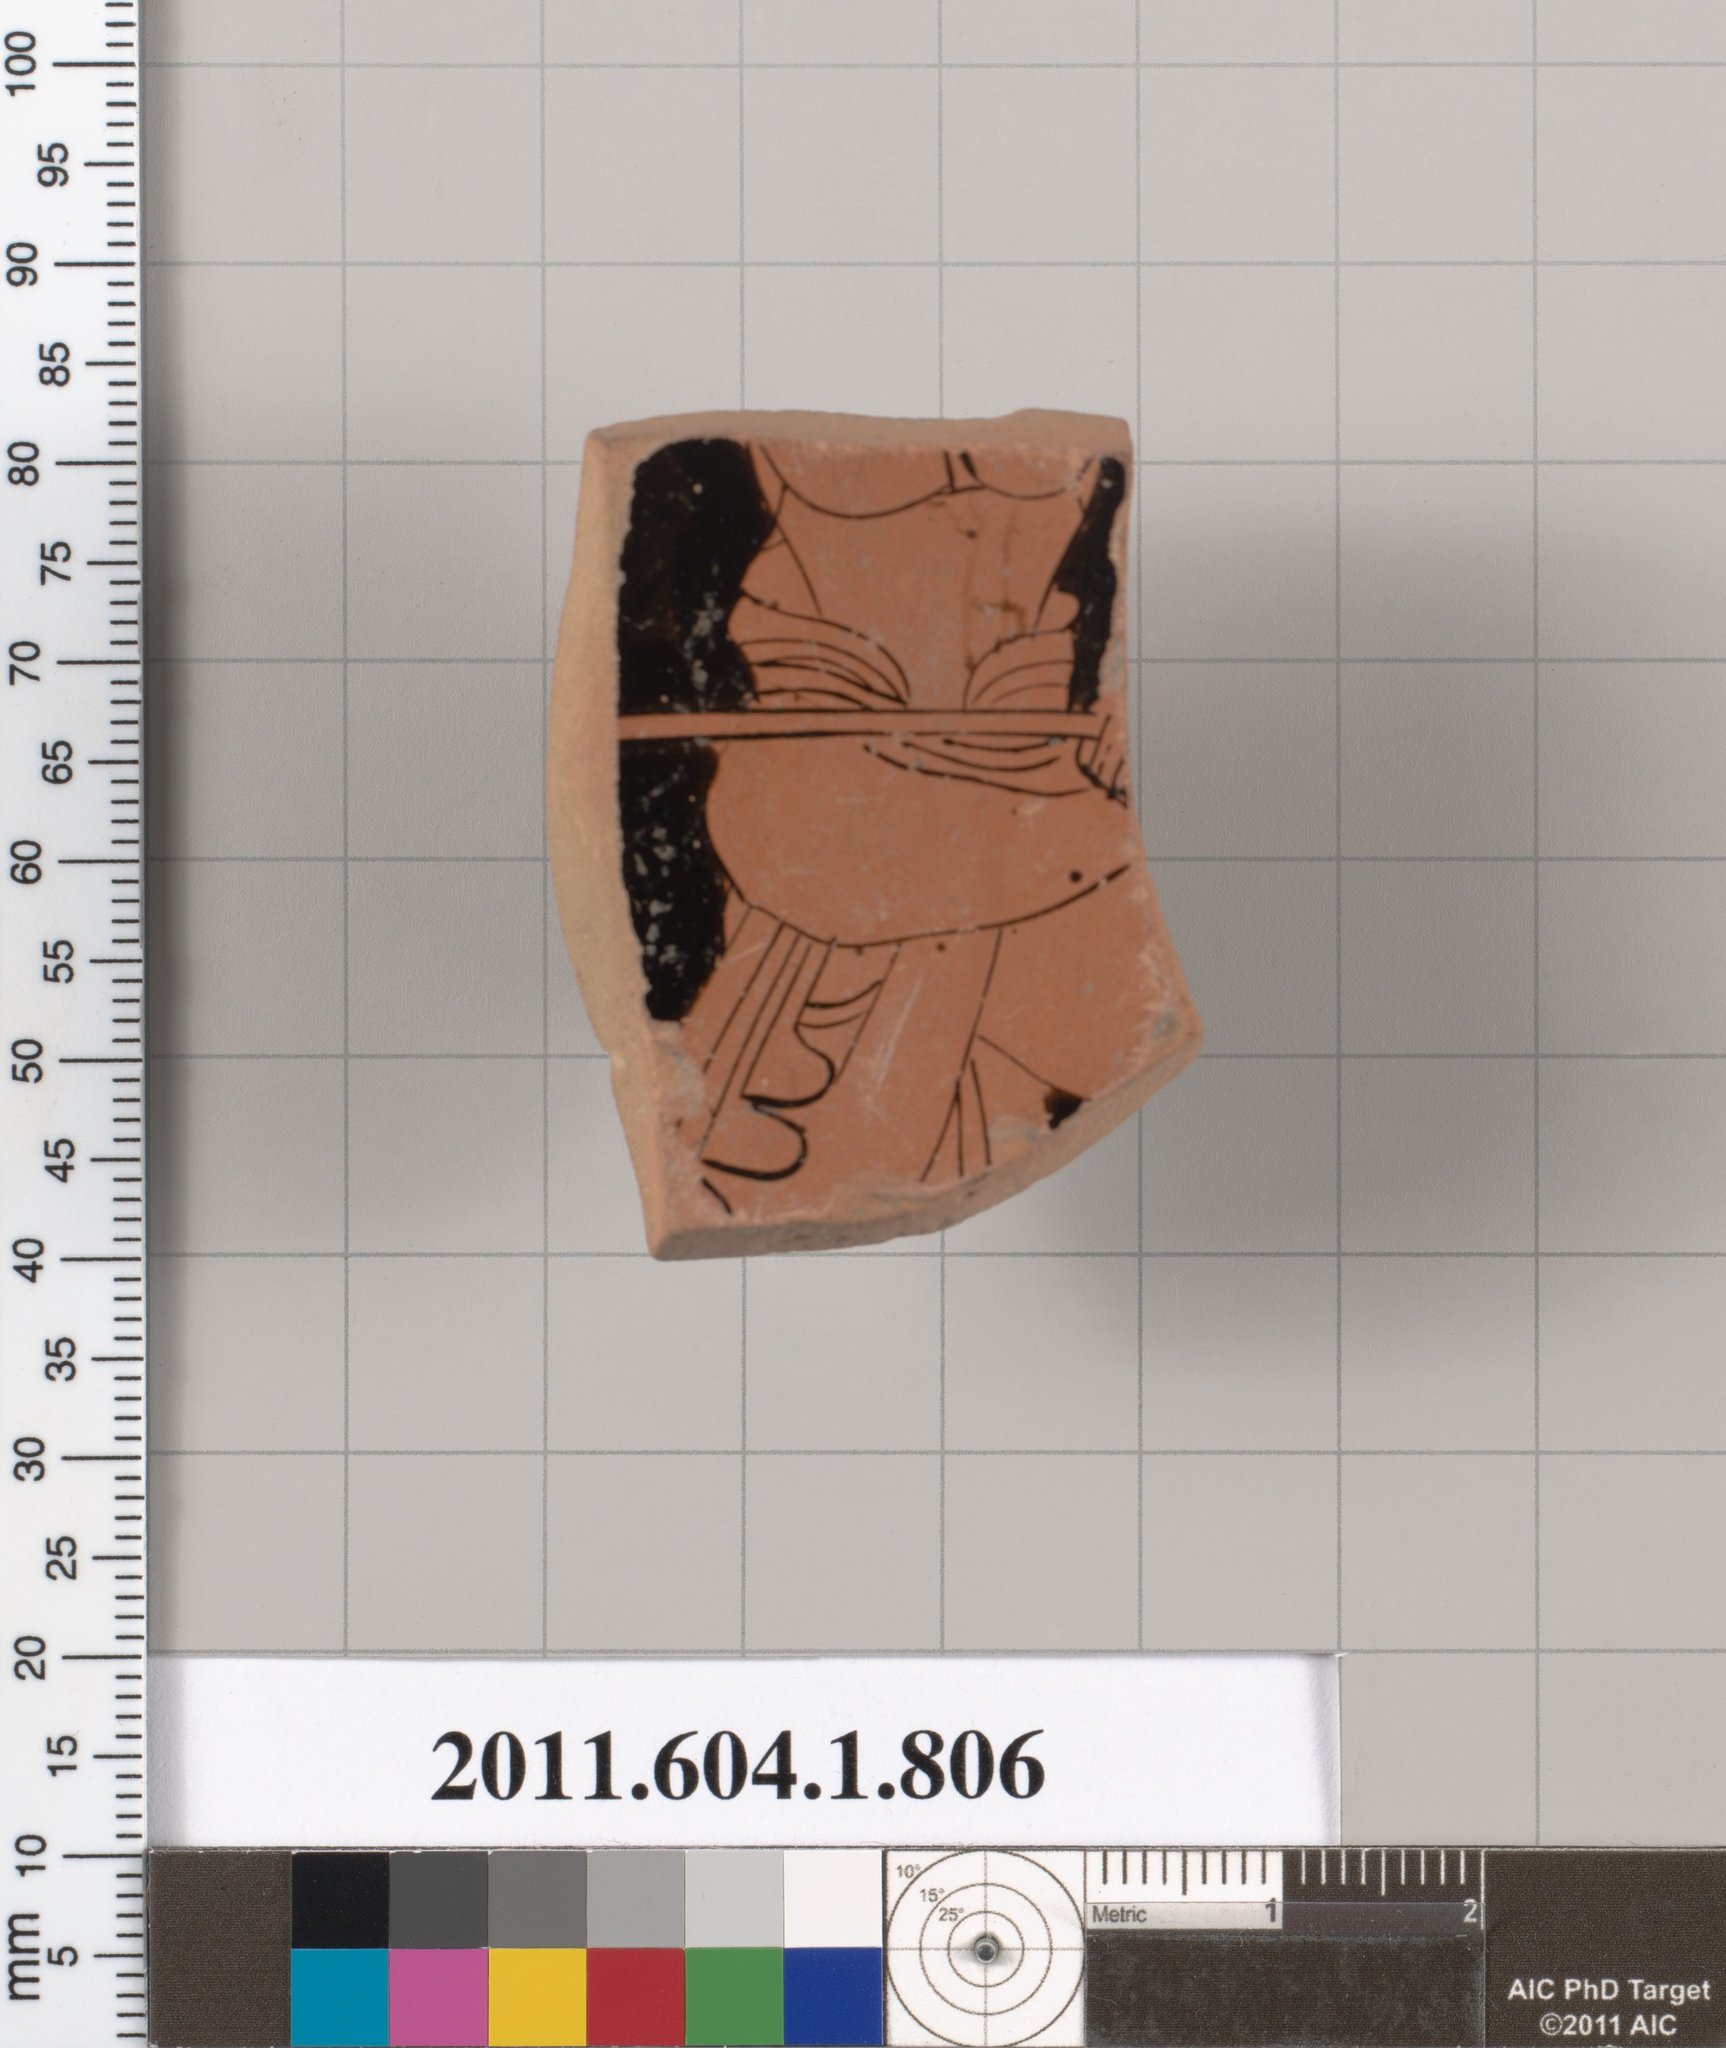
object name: kylix fragment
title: Terracotta fragment of a kylix (drinking cup)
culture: greek, attic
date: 475-451 BCE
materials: terracotta